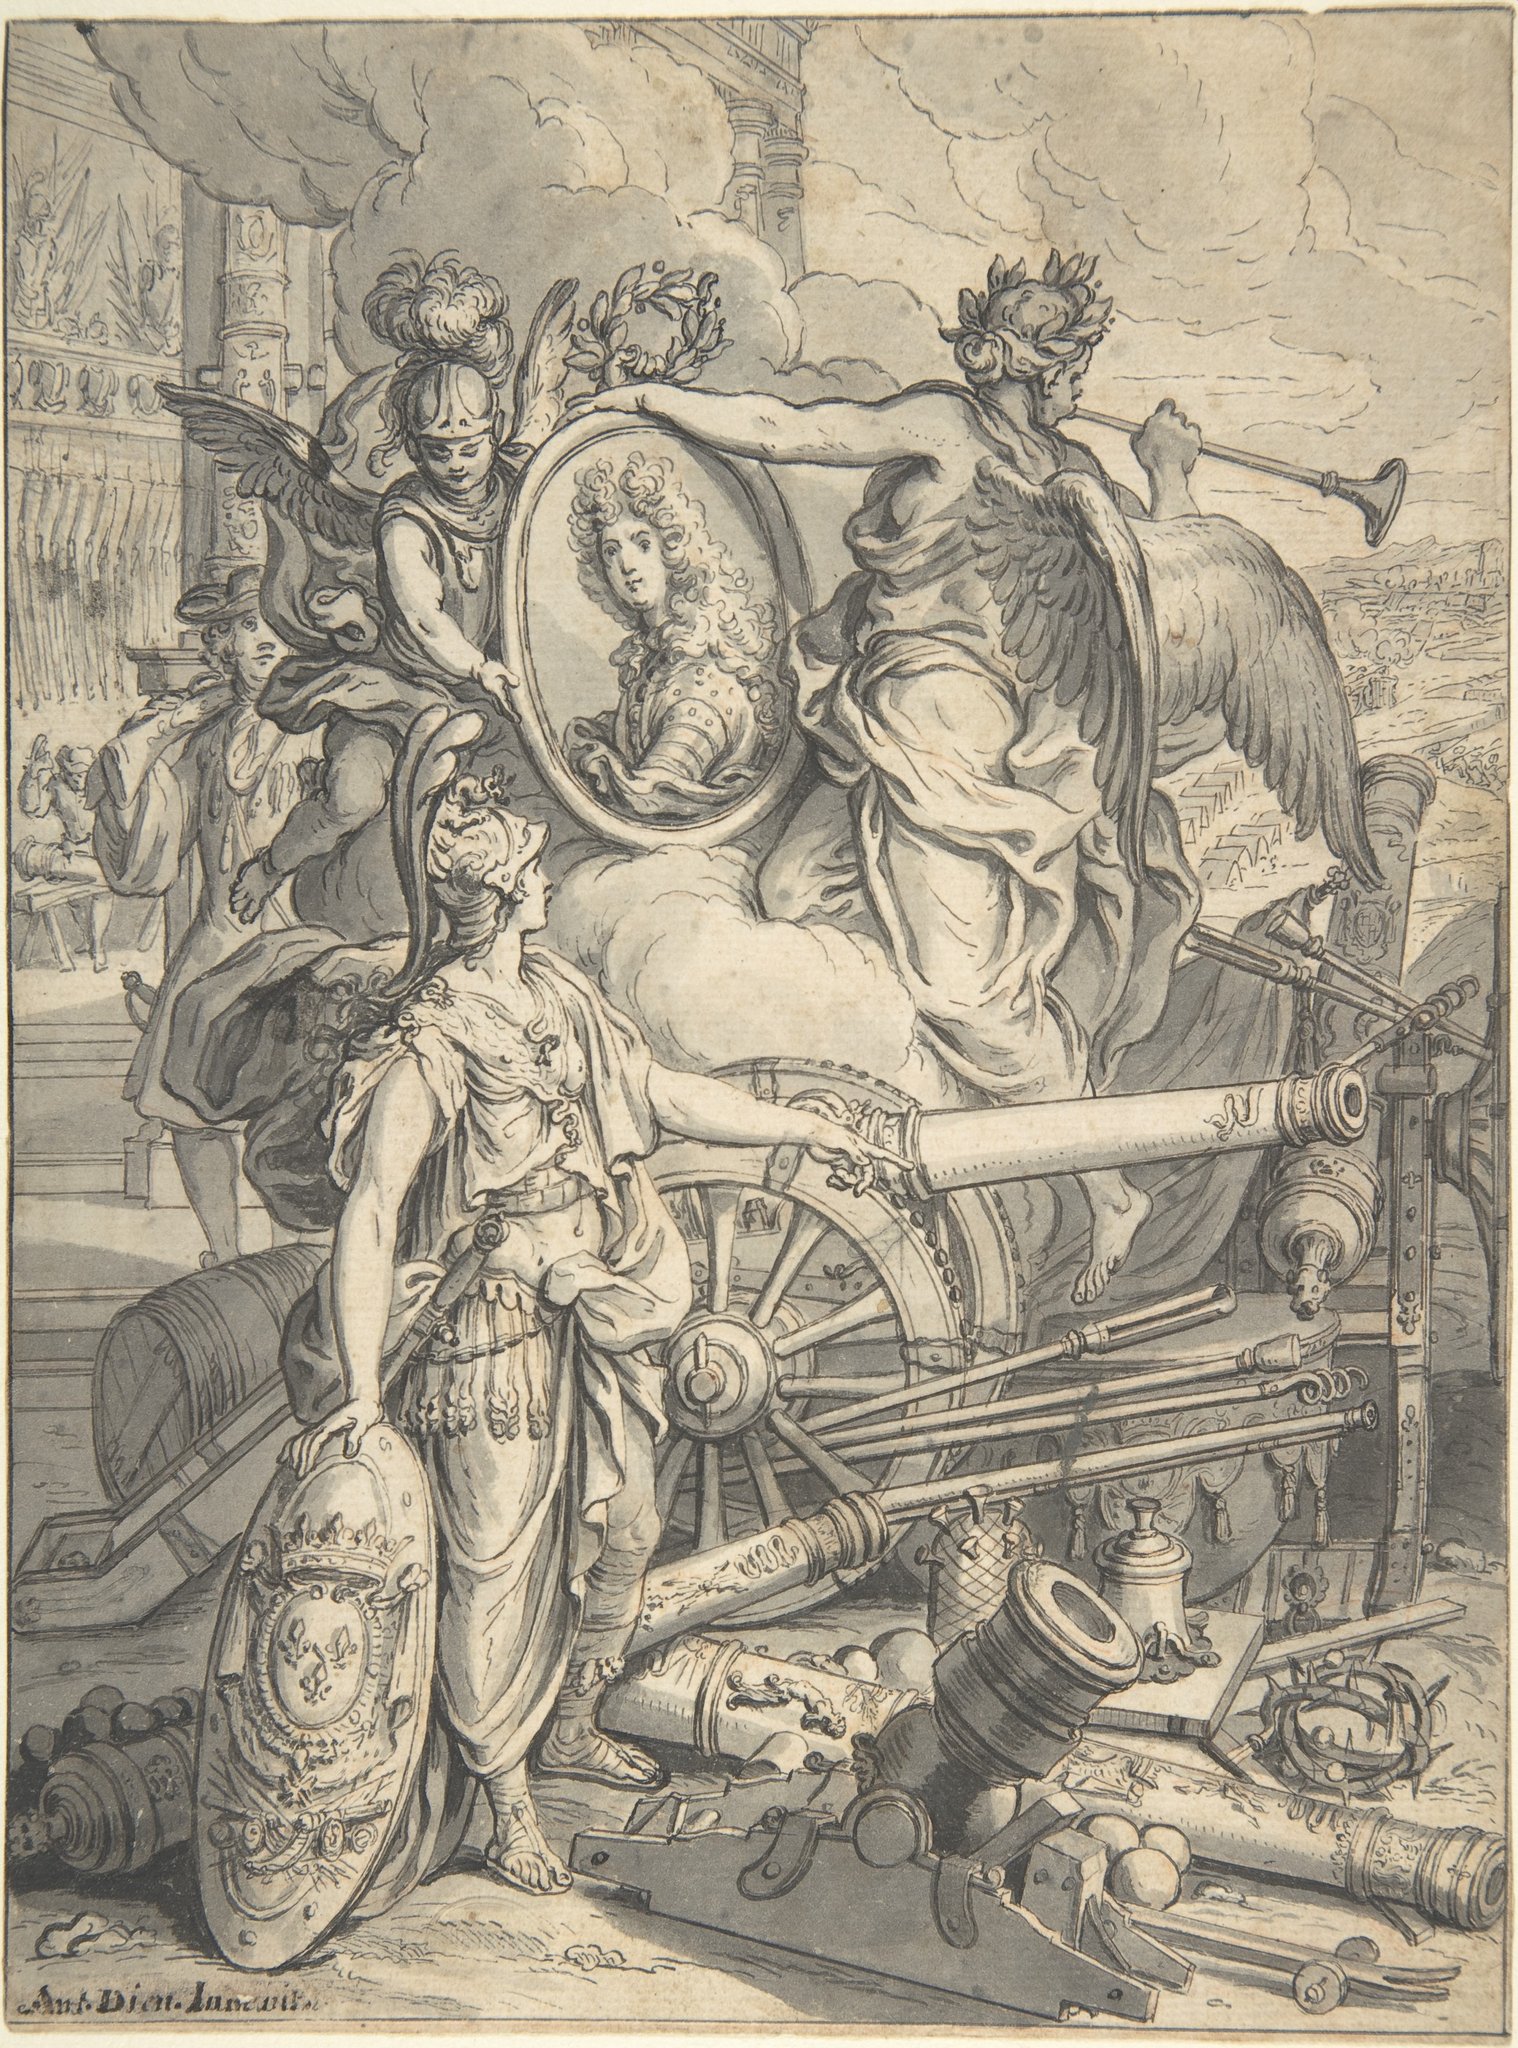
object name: drawing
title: Allegorical Homage to the Duc du Maine, Grand Maître de l'Artillerie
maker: antoine dieu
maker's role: artist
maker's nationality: french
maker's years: 1662-1727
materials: chalk, ink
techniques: pen, wash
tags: musical instruments,shields,cannons,women